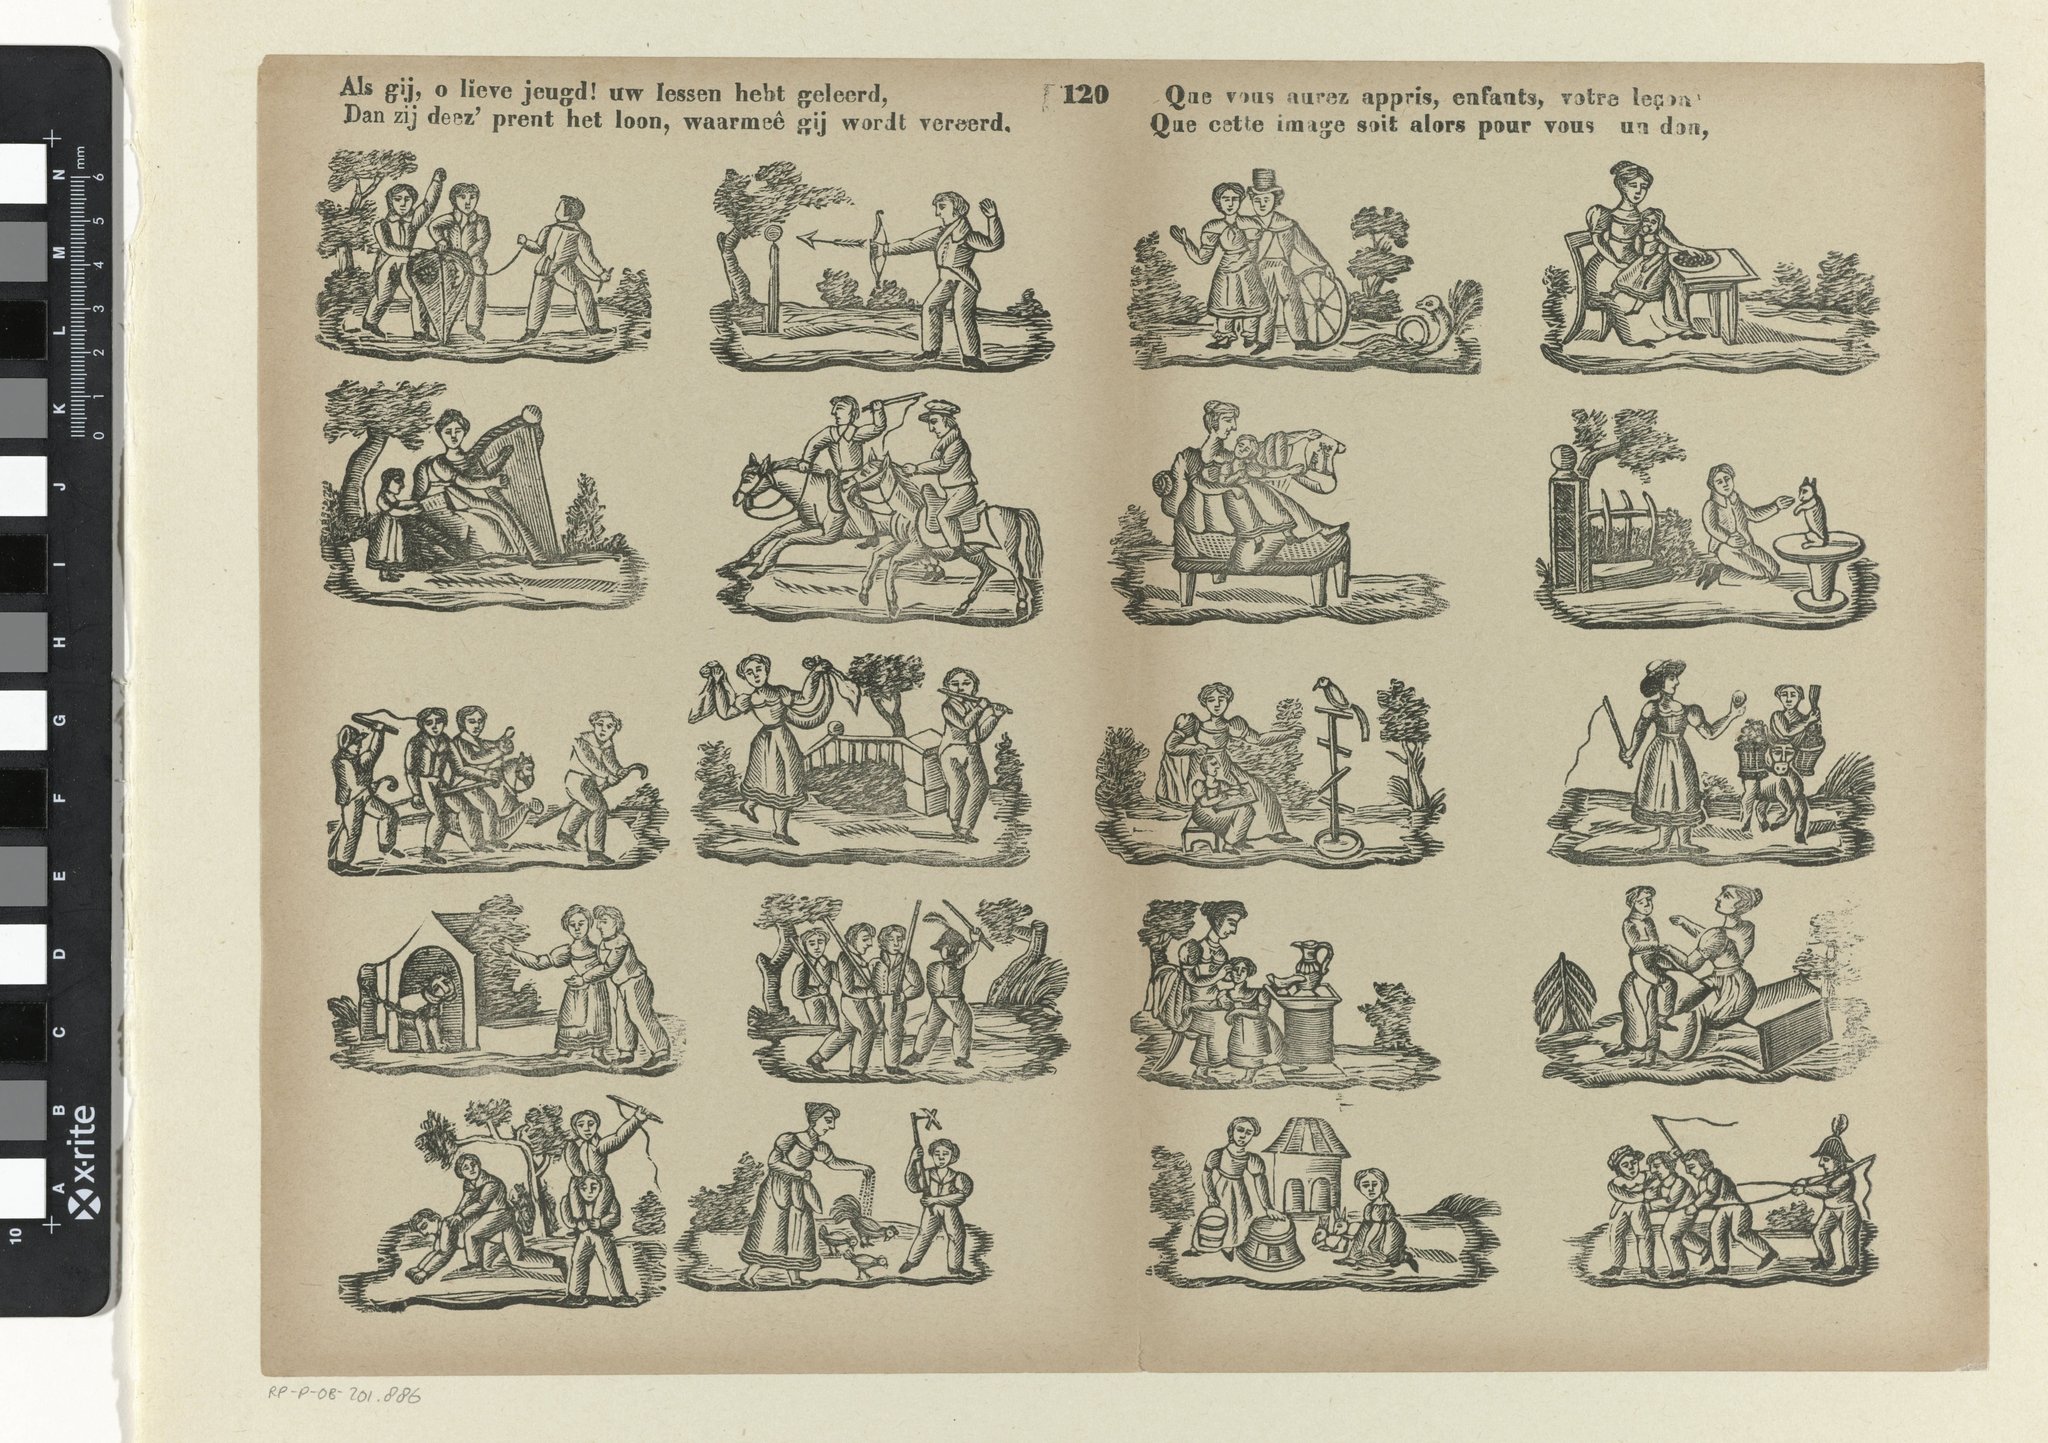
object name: print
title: Als gij, o lieve jeugd! uw lessen hebt geleerd, / Dan zij deez' prent het loon, waarmeê gij wordt vereerd / Que vous aurez appris, enfants, votre leçon / Que cette image soit alors pour vous un don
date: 1800-1833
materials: paper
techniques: letterpress printing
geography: turnhout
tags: children's games and plays, making music; musician with instrument, feeding wild animals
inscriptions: collector's mark: Lugt 2760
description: Blad met 20 voorstellingen van verschillende kinderspelen en bezigheden, waaronder harp spelen, paardrijden en de kippen voeren. Genummerd midden boven: 120.